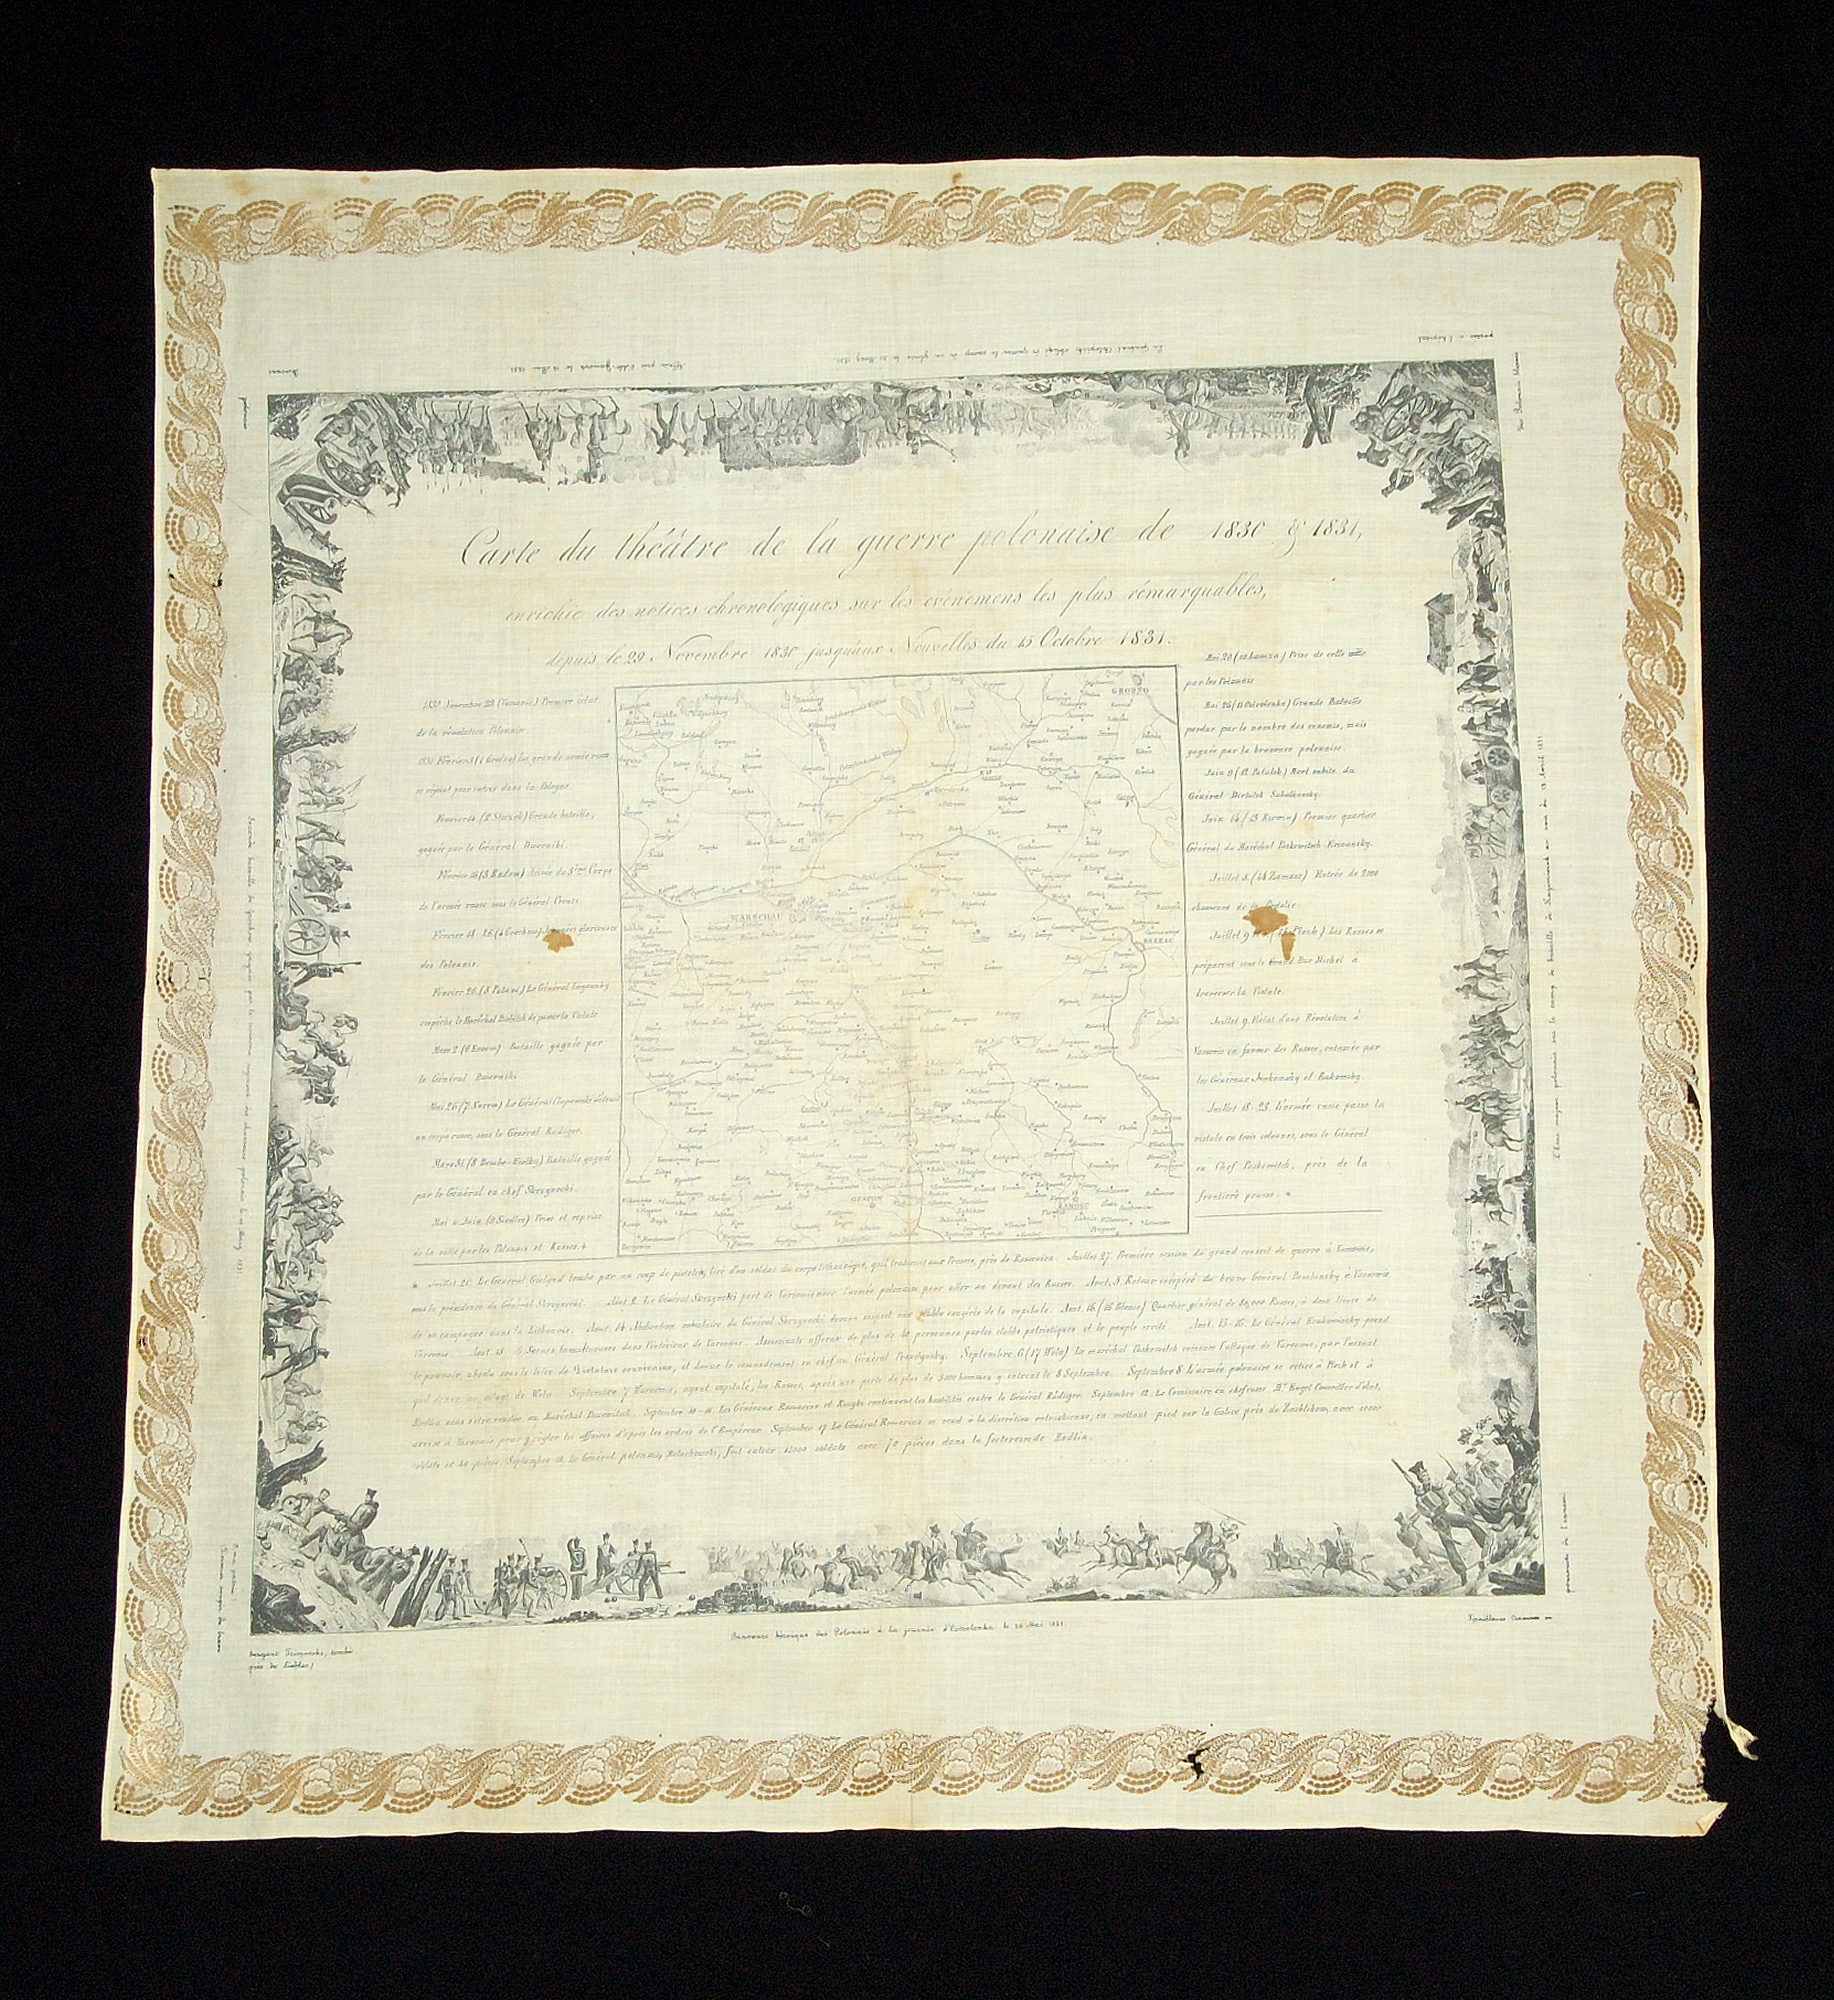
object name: handkerchief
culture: french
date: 1831-1832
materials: linen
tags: maps,documents